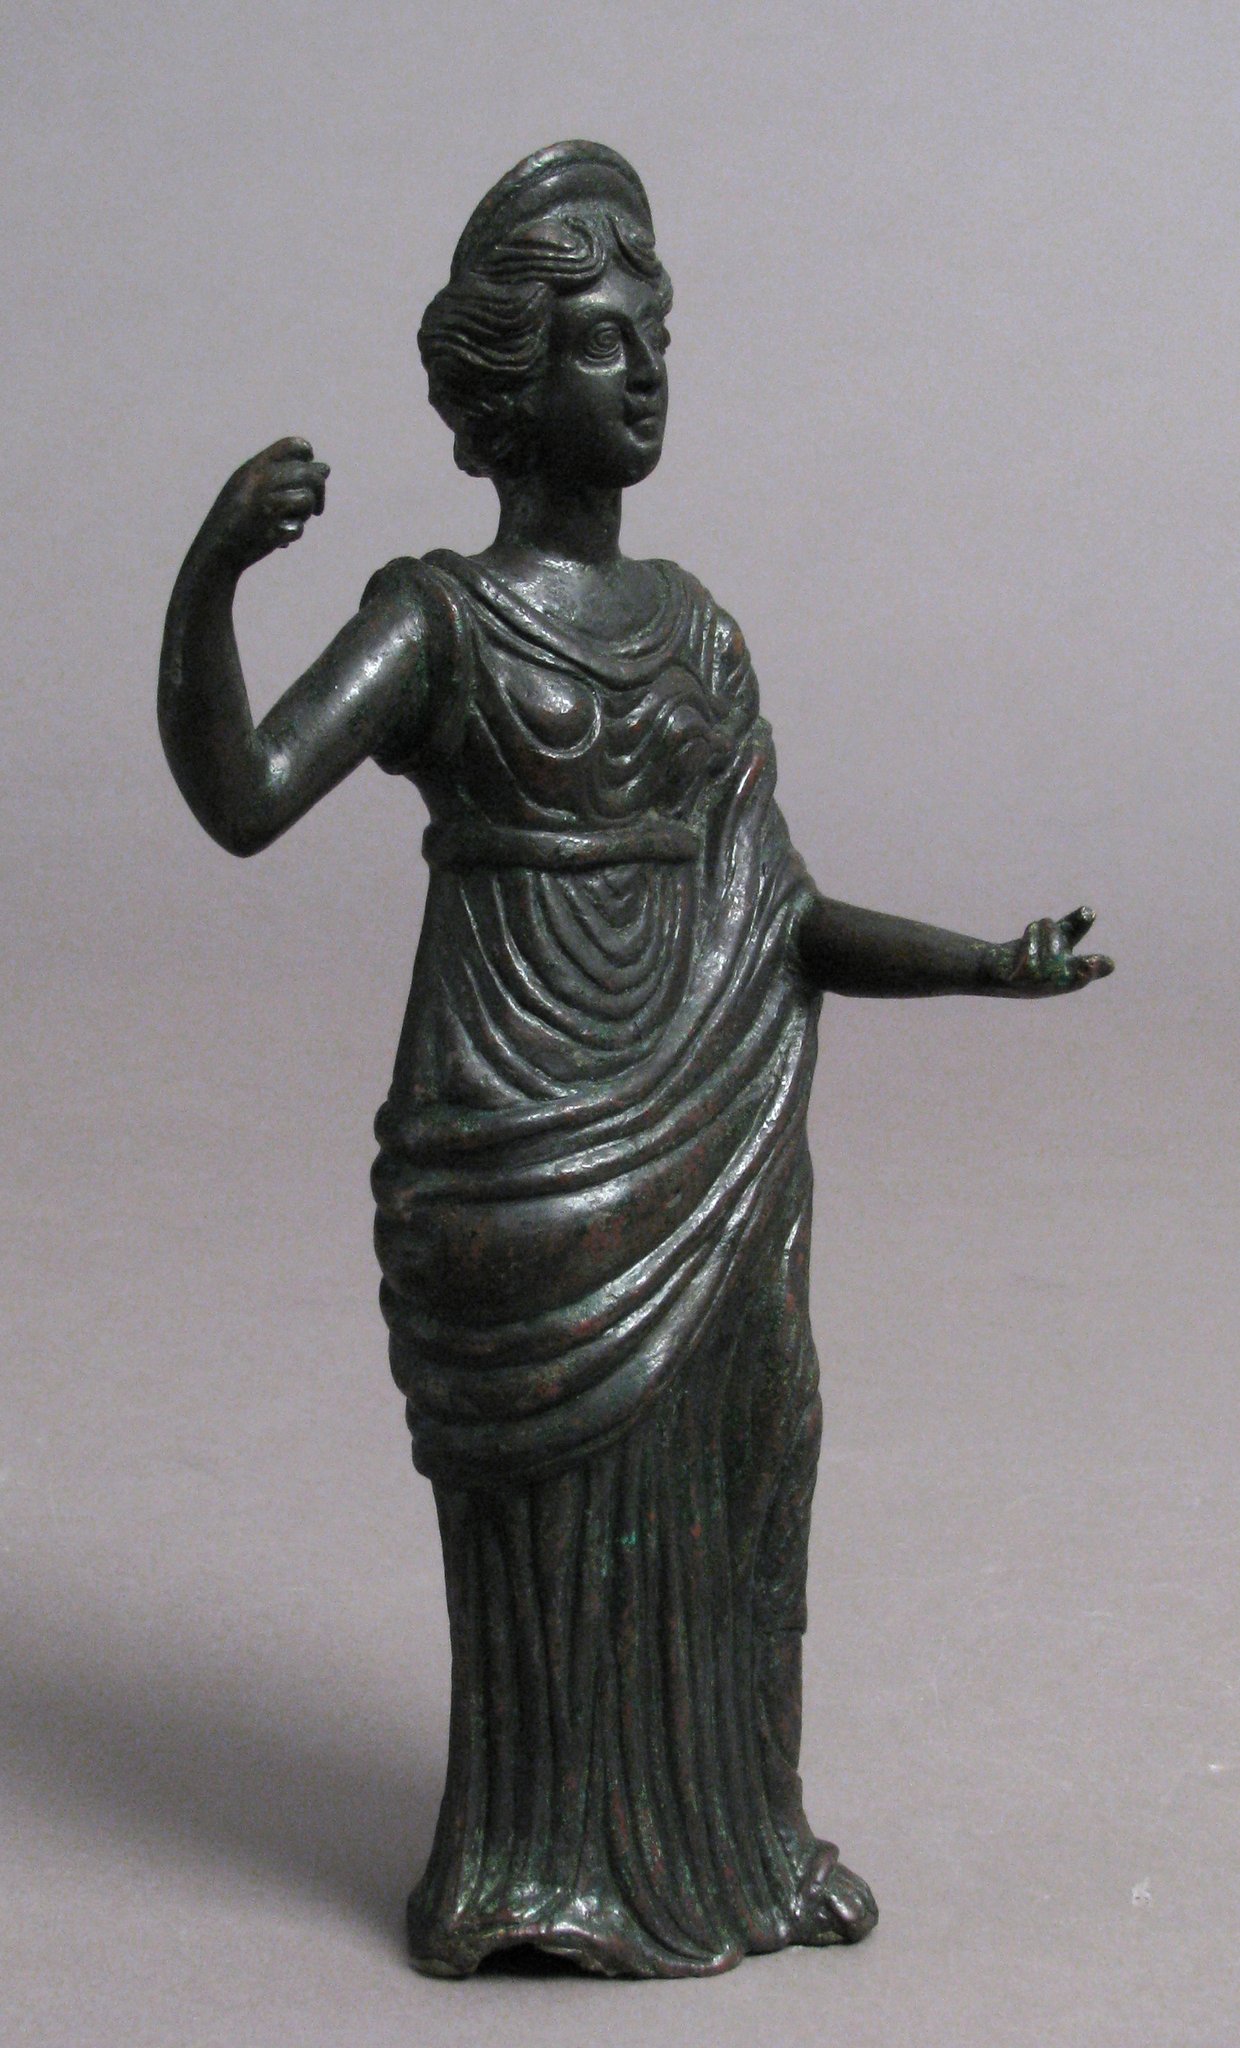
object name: figure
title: Statuette of a Woman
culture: byzantine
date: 401-600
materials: copper alloy